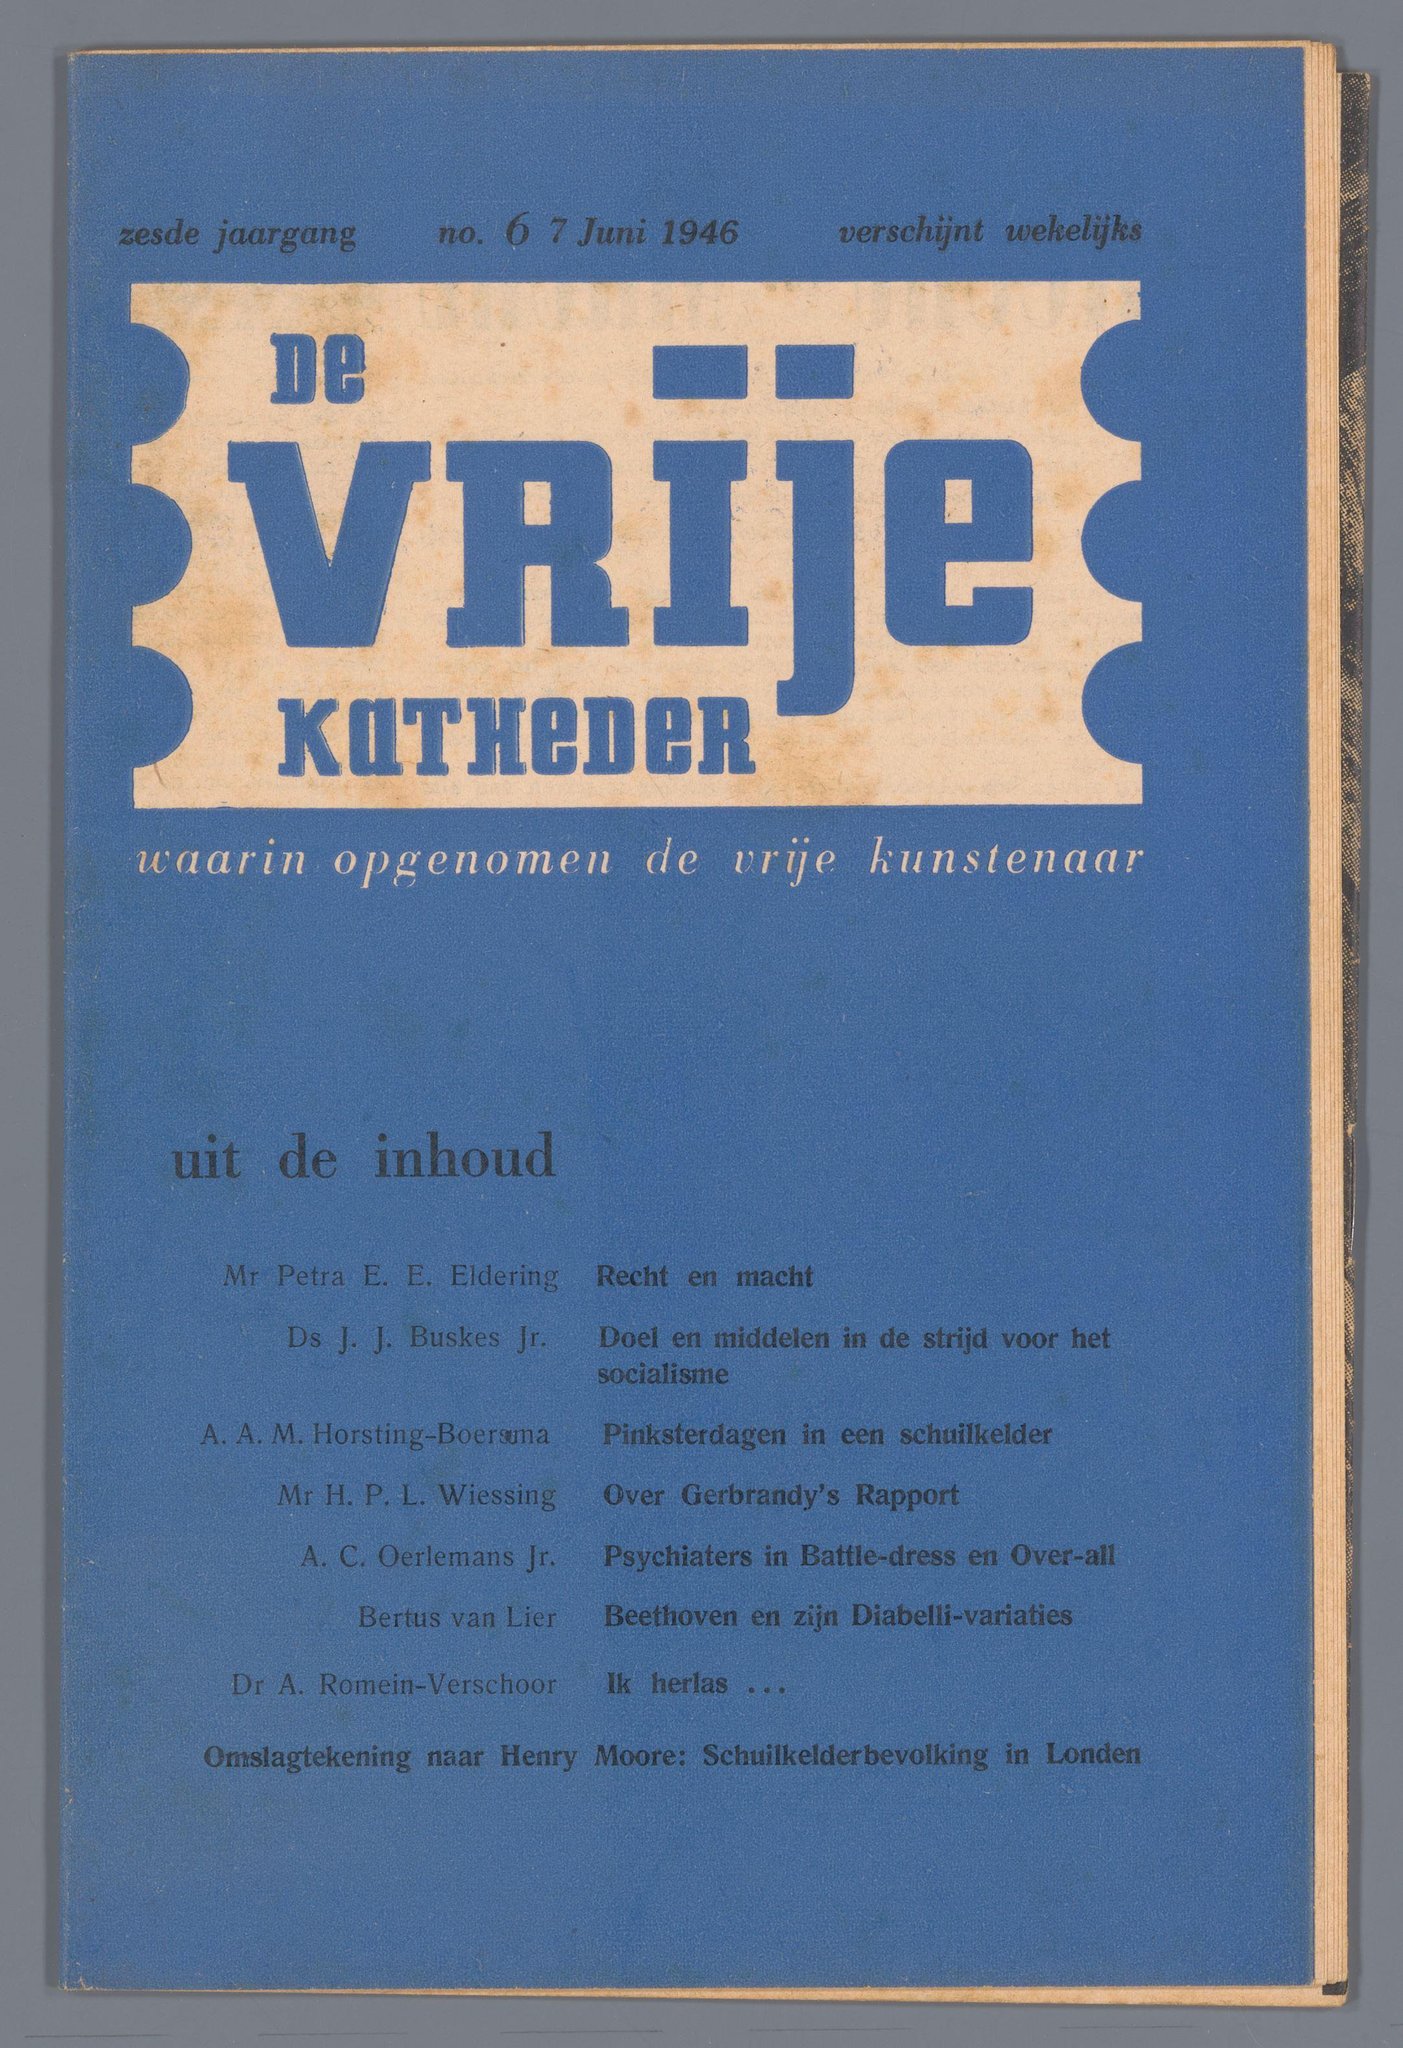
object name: magazine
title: De Vrije Katheder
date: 1946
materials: paper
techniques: printing, stapling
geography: amsterdam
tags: netherlands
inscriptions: date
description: Tijdschrift, jaargang 6 nr. 6 van 'De Vrije Katheder', pp 82 t/m 96. Gedateerd; midden boven: 7 Juni 1946.